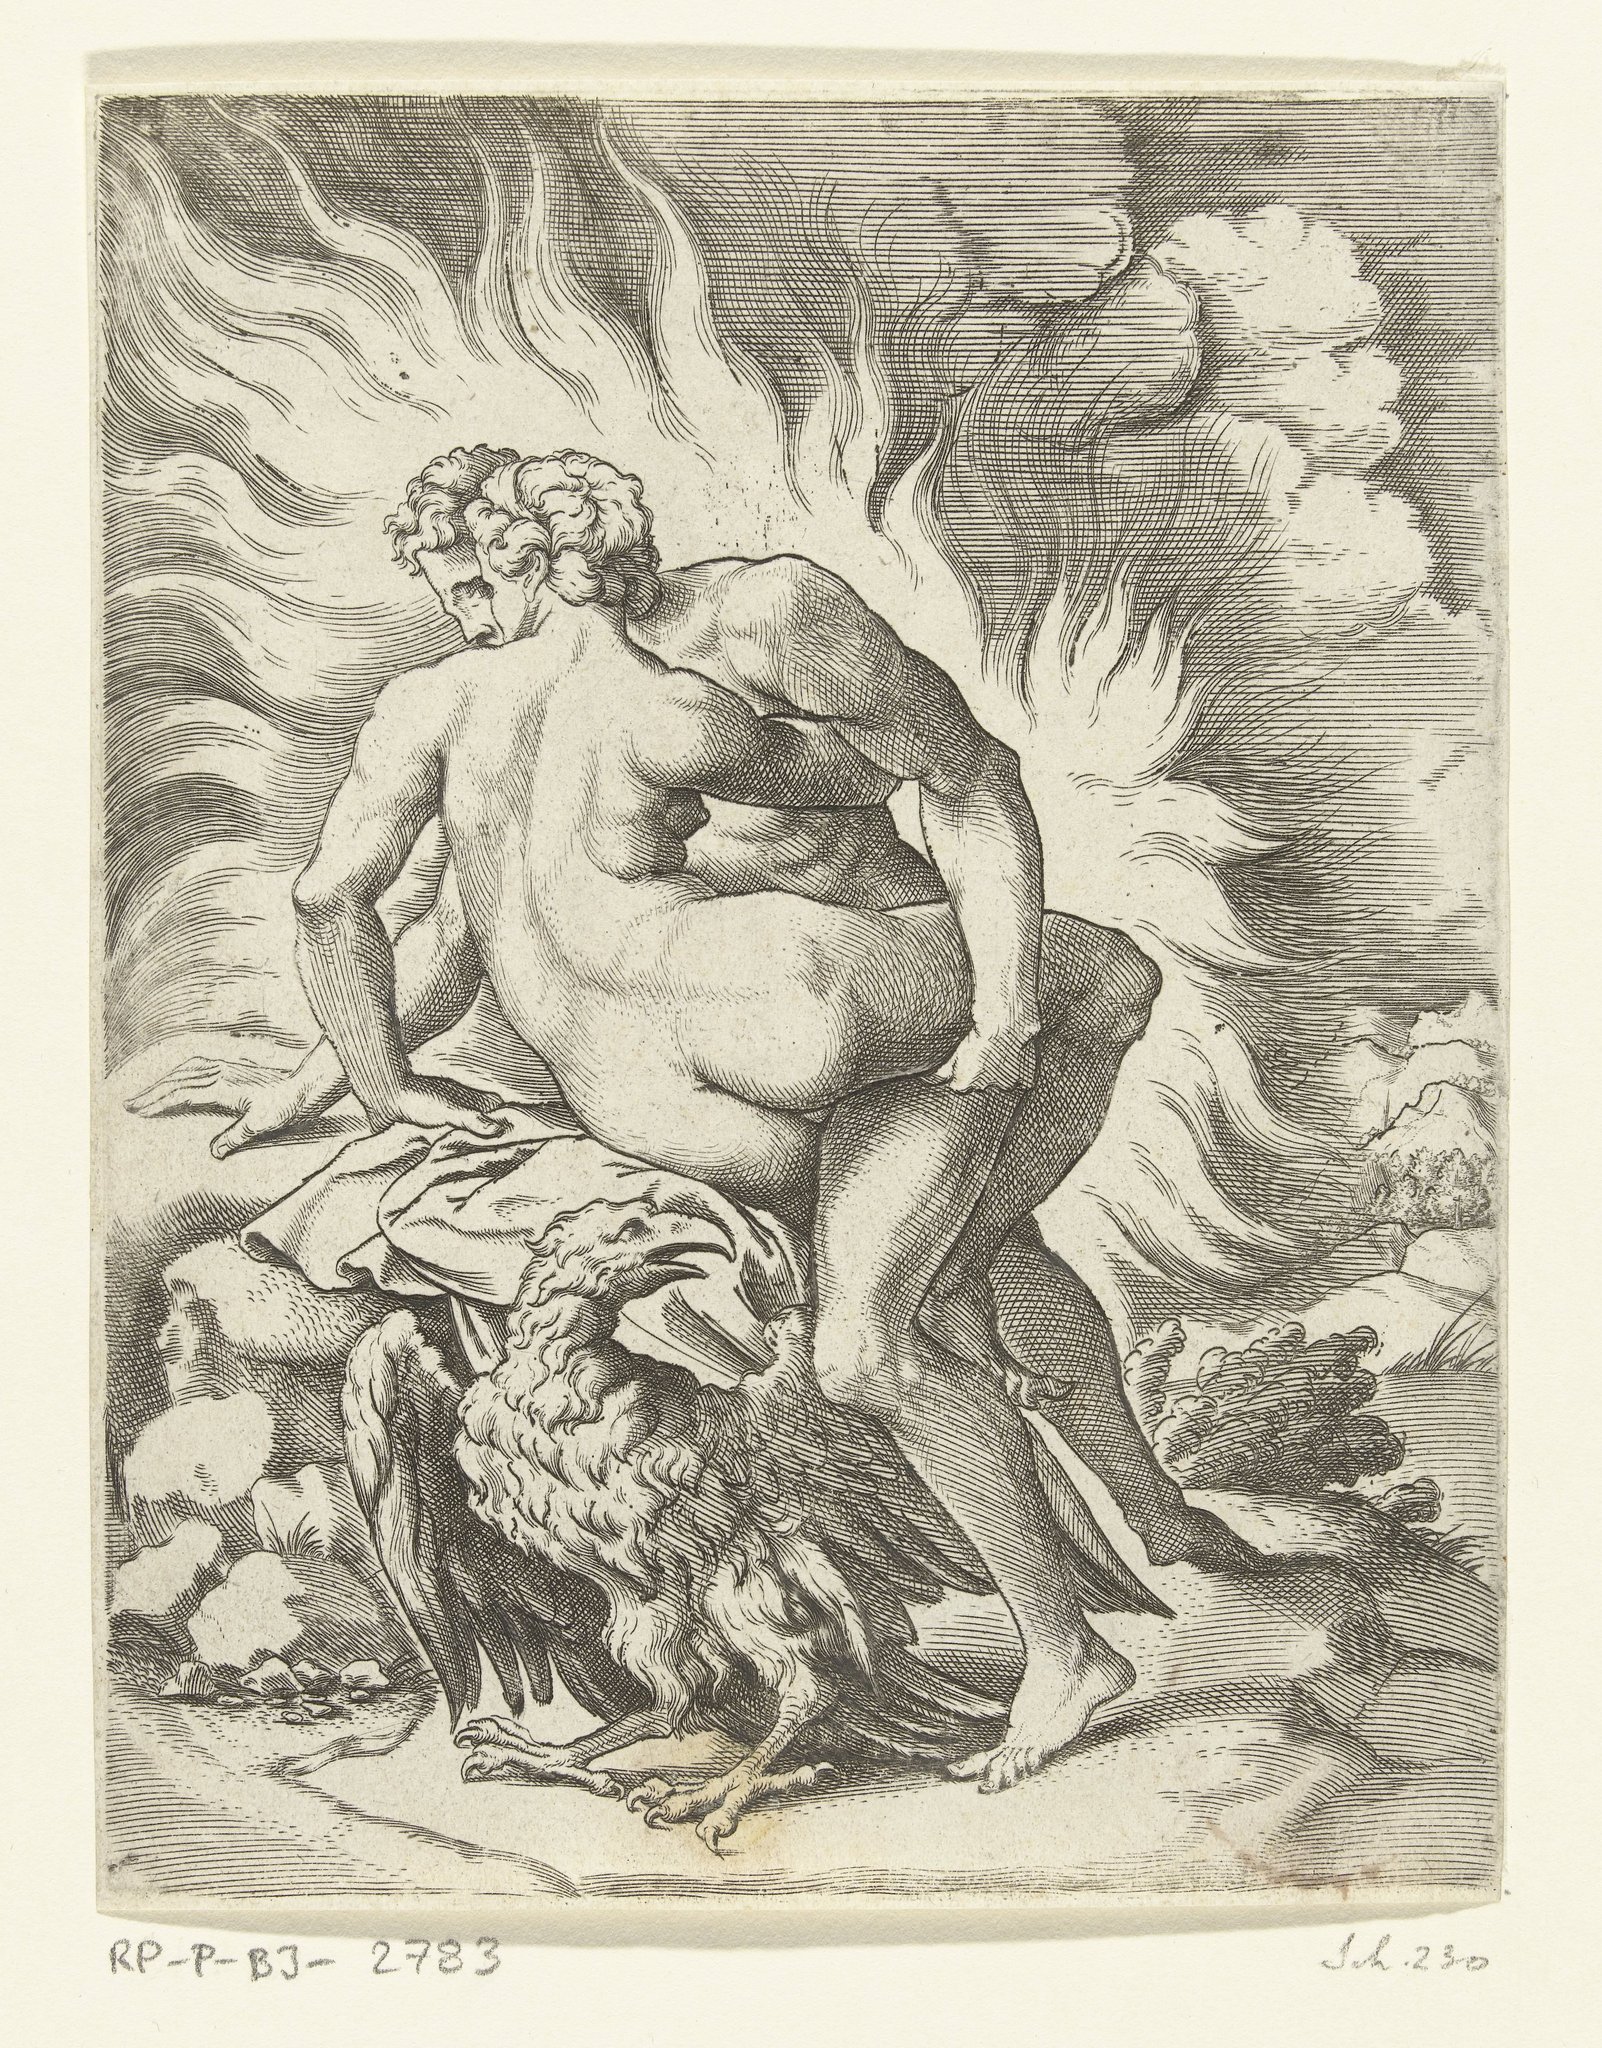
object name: print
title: Jupiter en Aegina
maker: cornelis bos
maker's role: print maker, printer, publisher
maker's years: 1510-1566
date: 1537-1555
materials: paper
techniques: engraving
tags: jupiter, in the form of an eagle or a flame, woos or abducts aegina, daughter of asopus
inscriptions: collector's mark: Lugt 2228, collector's mark: Lugt 240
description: In een stralenkrans van vuur verleidt Jupiter Aegina. Jupiters adelaar zit op de grond naast het vrijend paar. Prent uit een serie van 10 prenten die het liefdesleven van Jupiter illustreren.